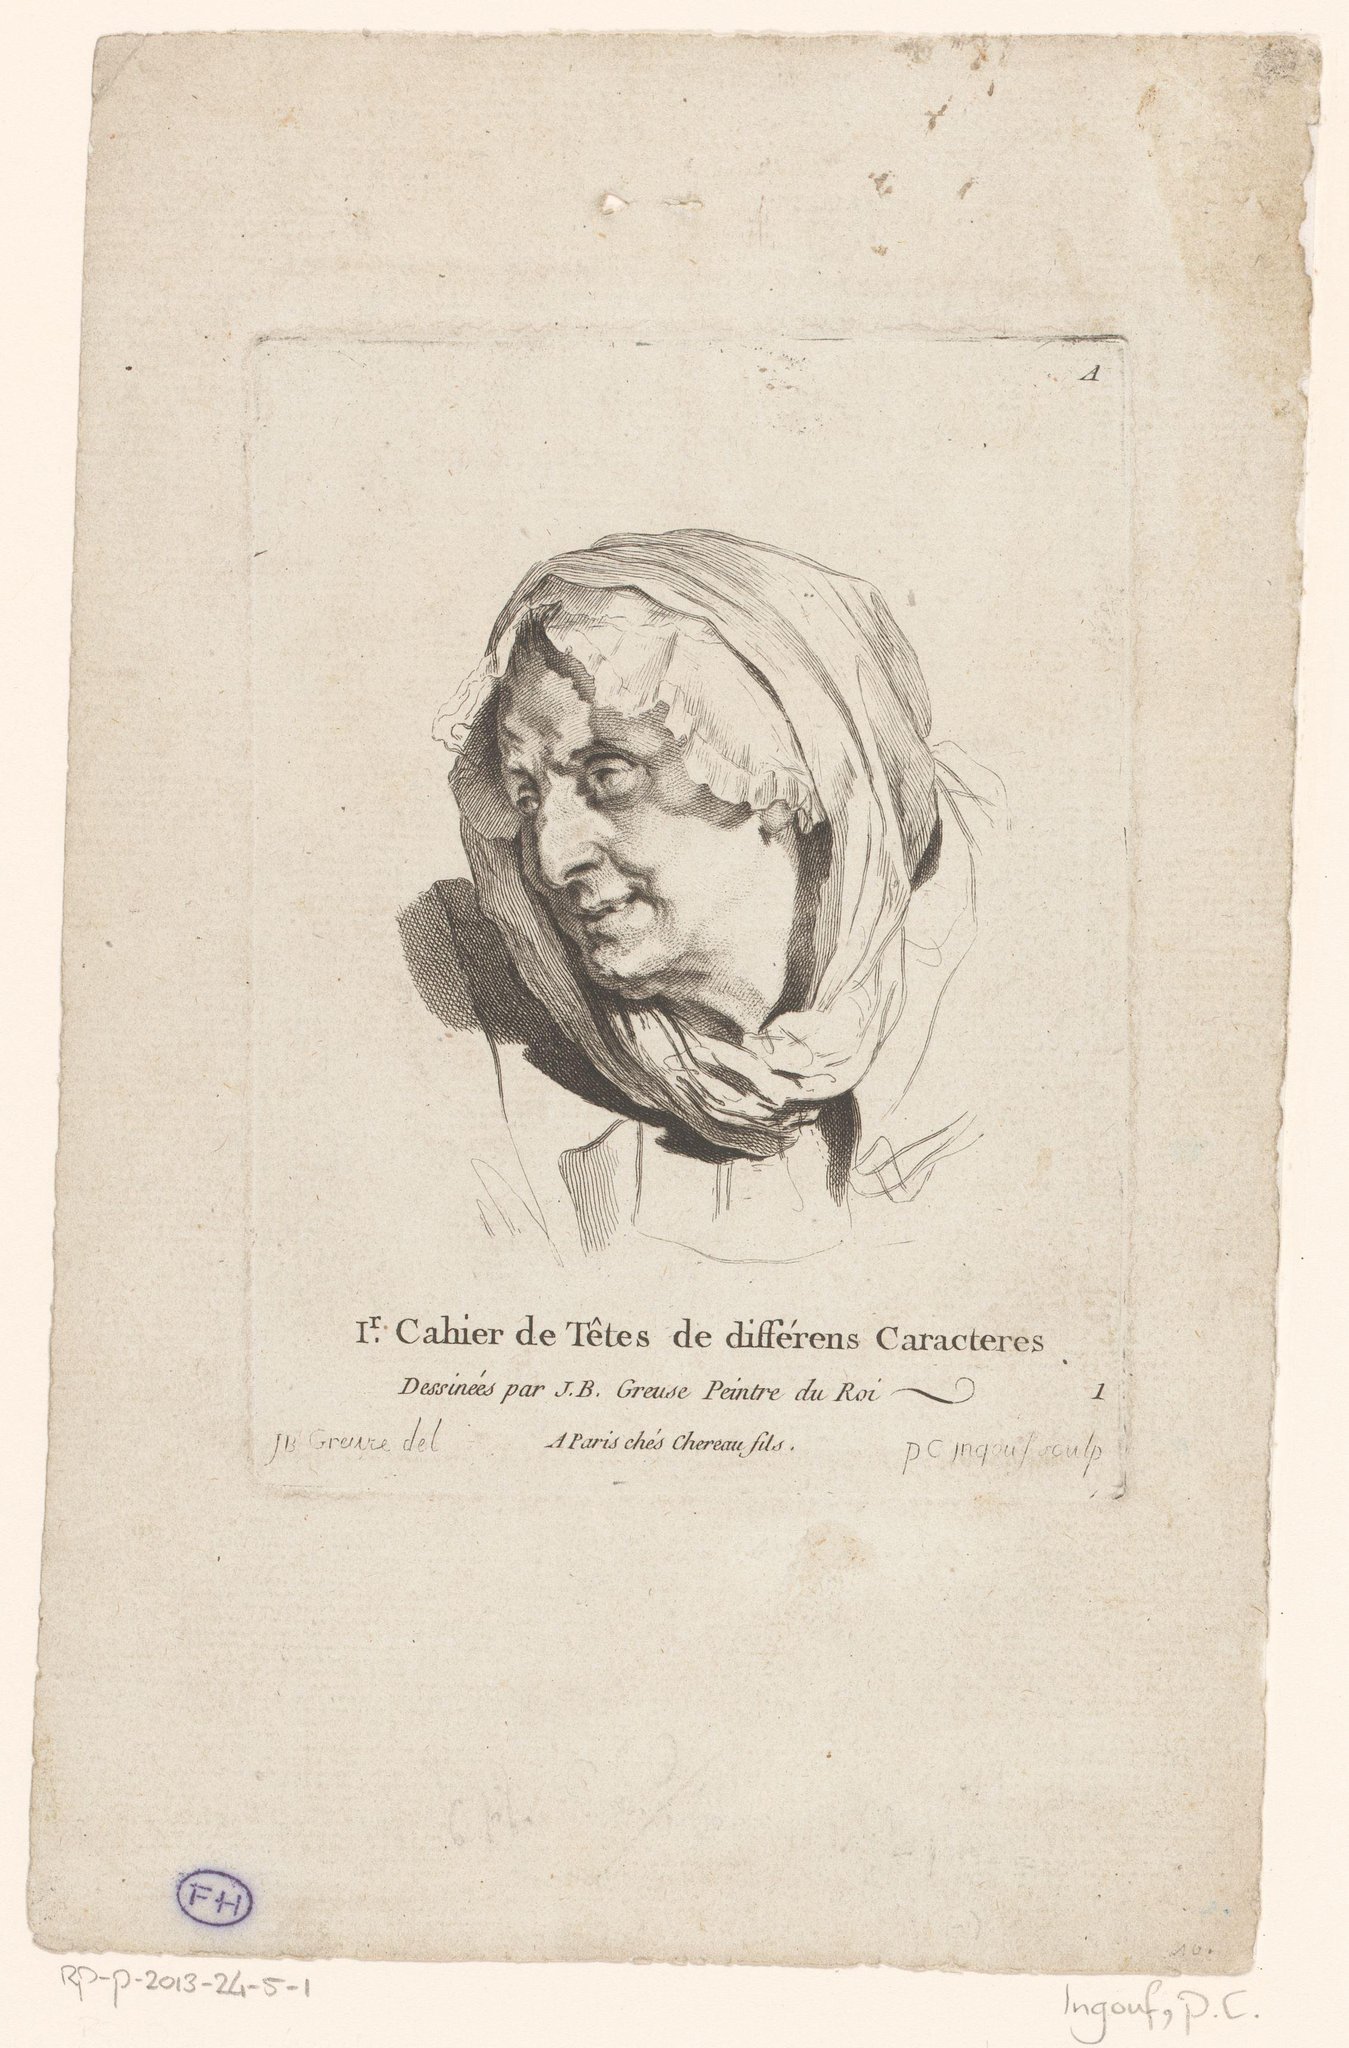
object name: titelprent, frontispice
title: Hoofden van verschillende figuren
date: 1766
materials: paper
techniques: engraving, etching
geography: france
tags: old woman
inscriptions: collector's mark: Lugt 3373, collector's mark: Lugt 2760, collector's mark: Lugt 2228, number: ‘a // 1’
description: Betreft de titelprent van een negendelige serie met hoofden van verschillende figuren.